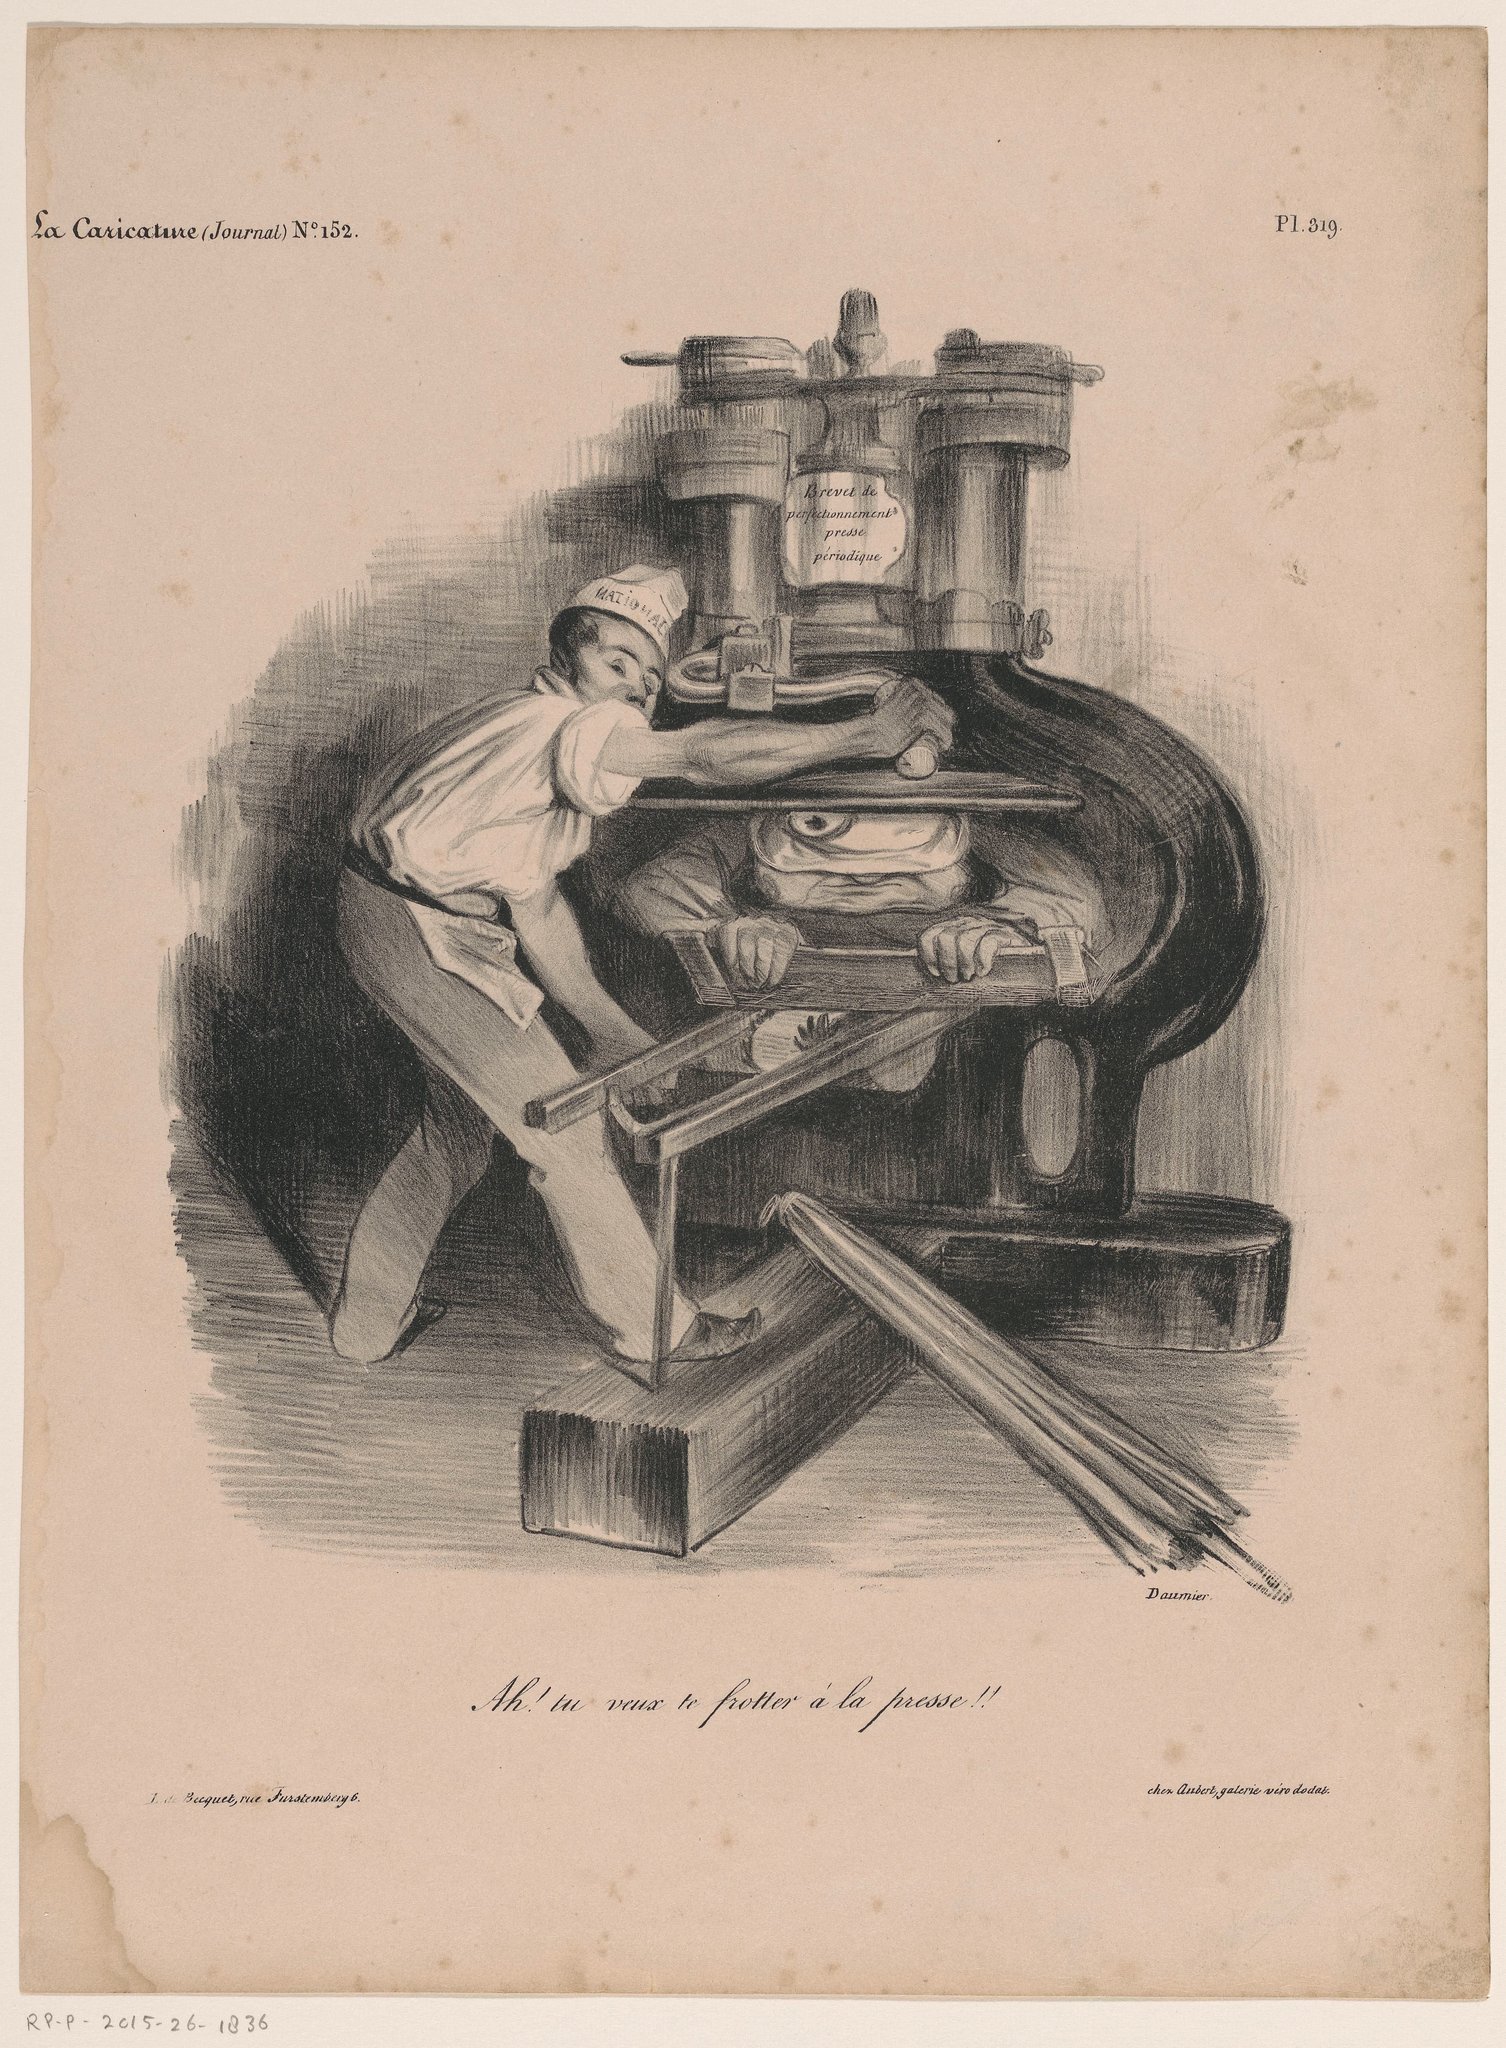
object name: print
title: Ah! tu veux te frotter à la presse!!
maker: honoré daumier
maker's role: draughtsman, painter, print maker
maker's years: 1808-1879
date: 1833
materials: paper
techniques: lithograph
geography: paris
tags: paris, lodewijk filips i (koning van frankrijk), printing press, political caricatures and satires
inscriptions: collector's mark: Lugt 4779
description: Een drukker draait aan een drukpers met daaronder koning Lodewijk Filips I van Frankrijk. Zijn paraplu ligt op de grond voor de drukpers.